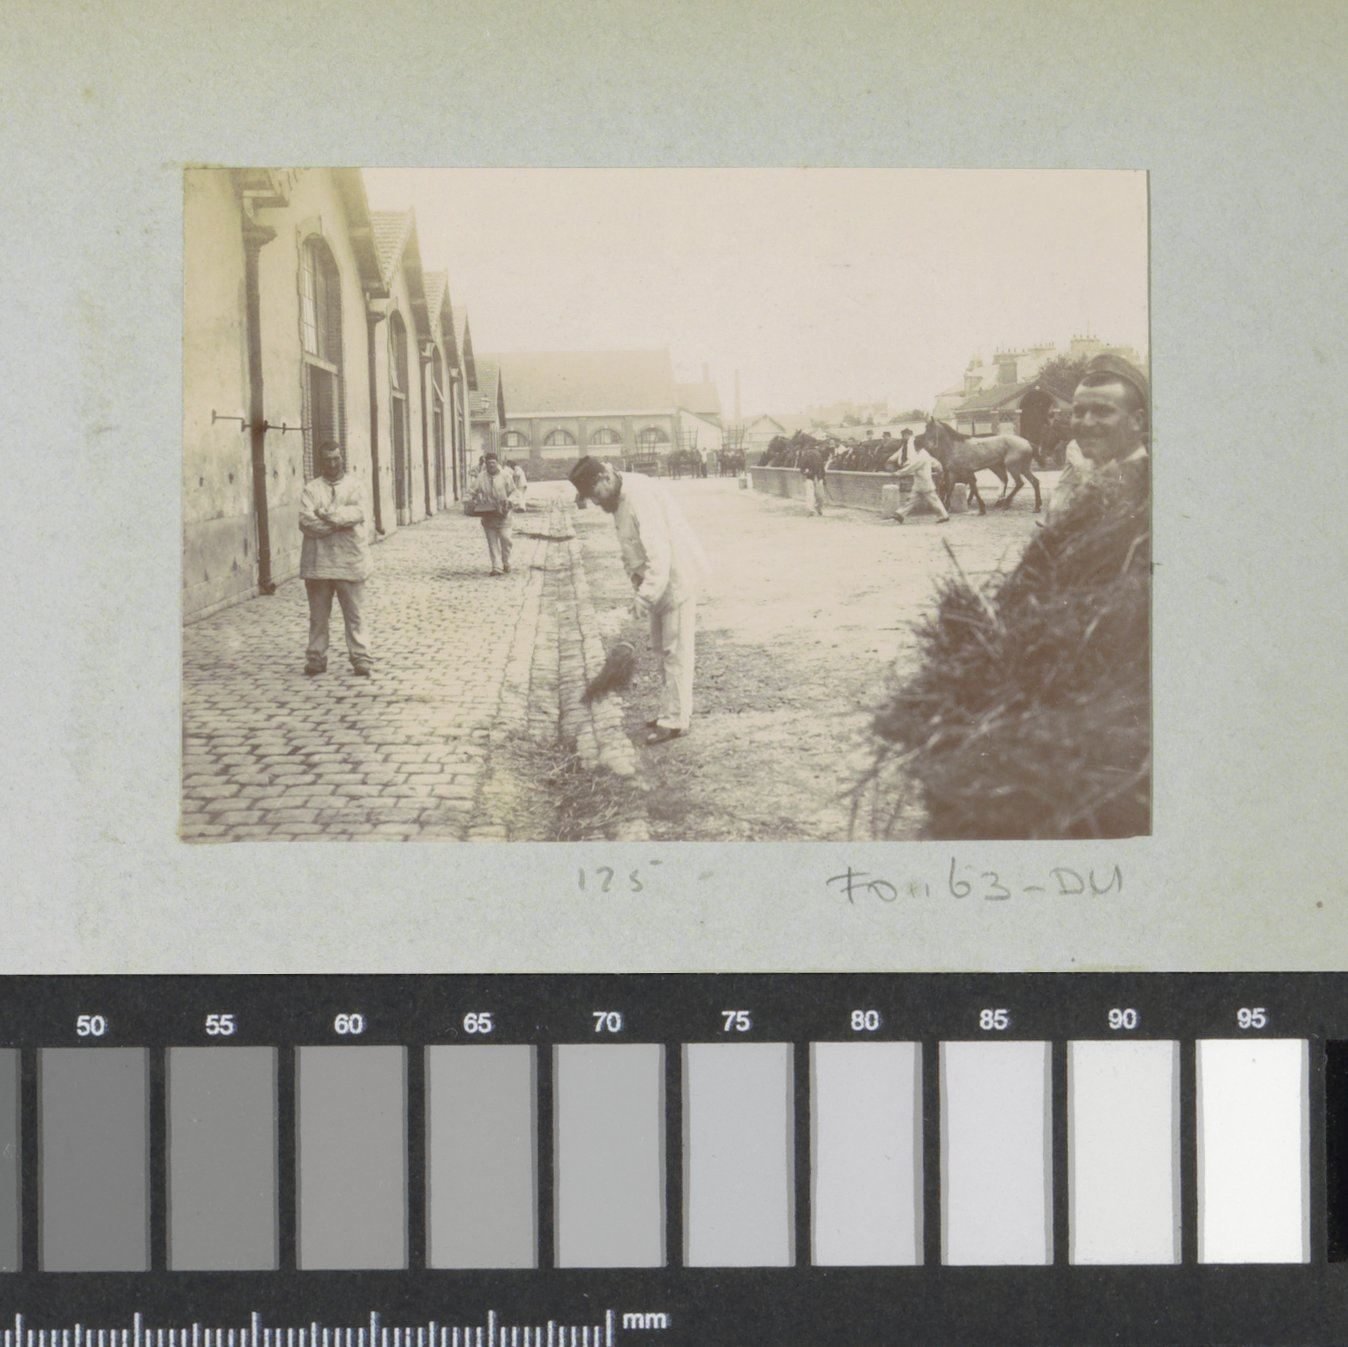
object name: photograph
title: Straatvegers, vermoedelijk in Pontoise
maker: delizy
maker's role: manufacturer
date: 1897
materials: paper, photographic support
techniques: gelatin silver print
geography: pontoise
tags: street sweeping, street sweeper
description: Onderdeel van Fotoalbum van een Franse amateurfotograaf met opnames van uitstapjes in Frankrijk, Spanje, België, Luxemburg en Nederland, de eerste automobielen en autoraces.